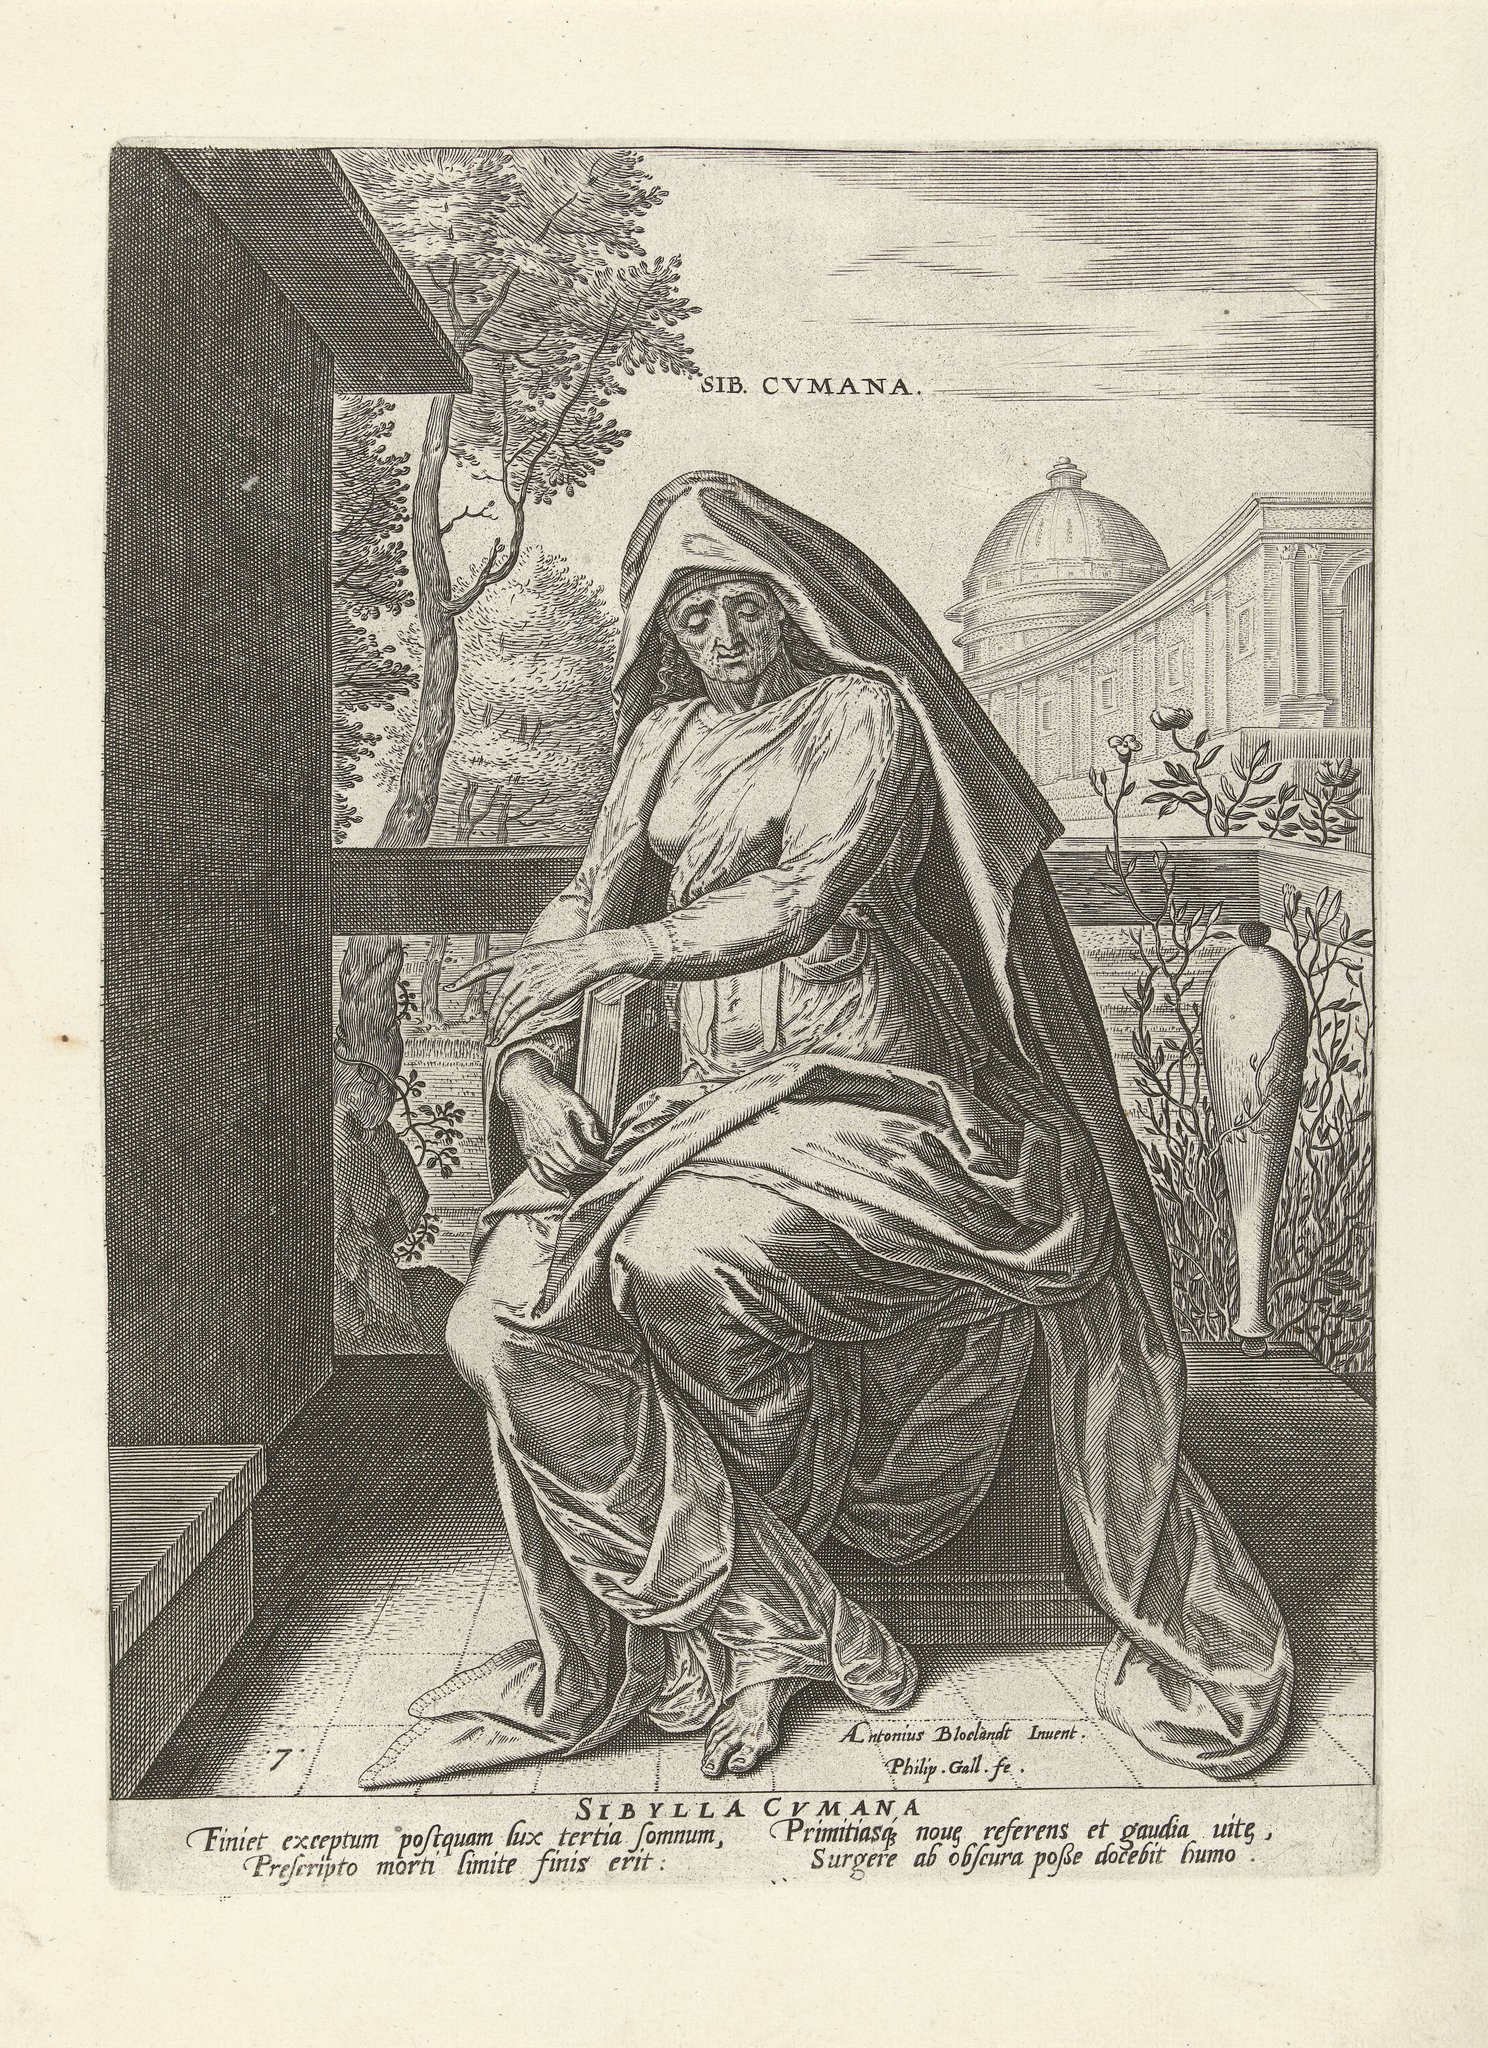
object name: print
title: Sibylla Cvmana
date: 1575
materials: paper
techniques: engraving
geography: antwerp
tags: sibyls (with name)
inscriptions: collector's mark: Lugt 2228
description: De Cimmerische Sibille, een oude vrouw, zit op een sokkel. Ze heeft een boek vast. De prent heeft een Latijns onderschrift en maakt deel uit van een tiendelige serie over de Sibillen.